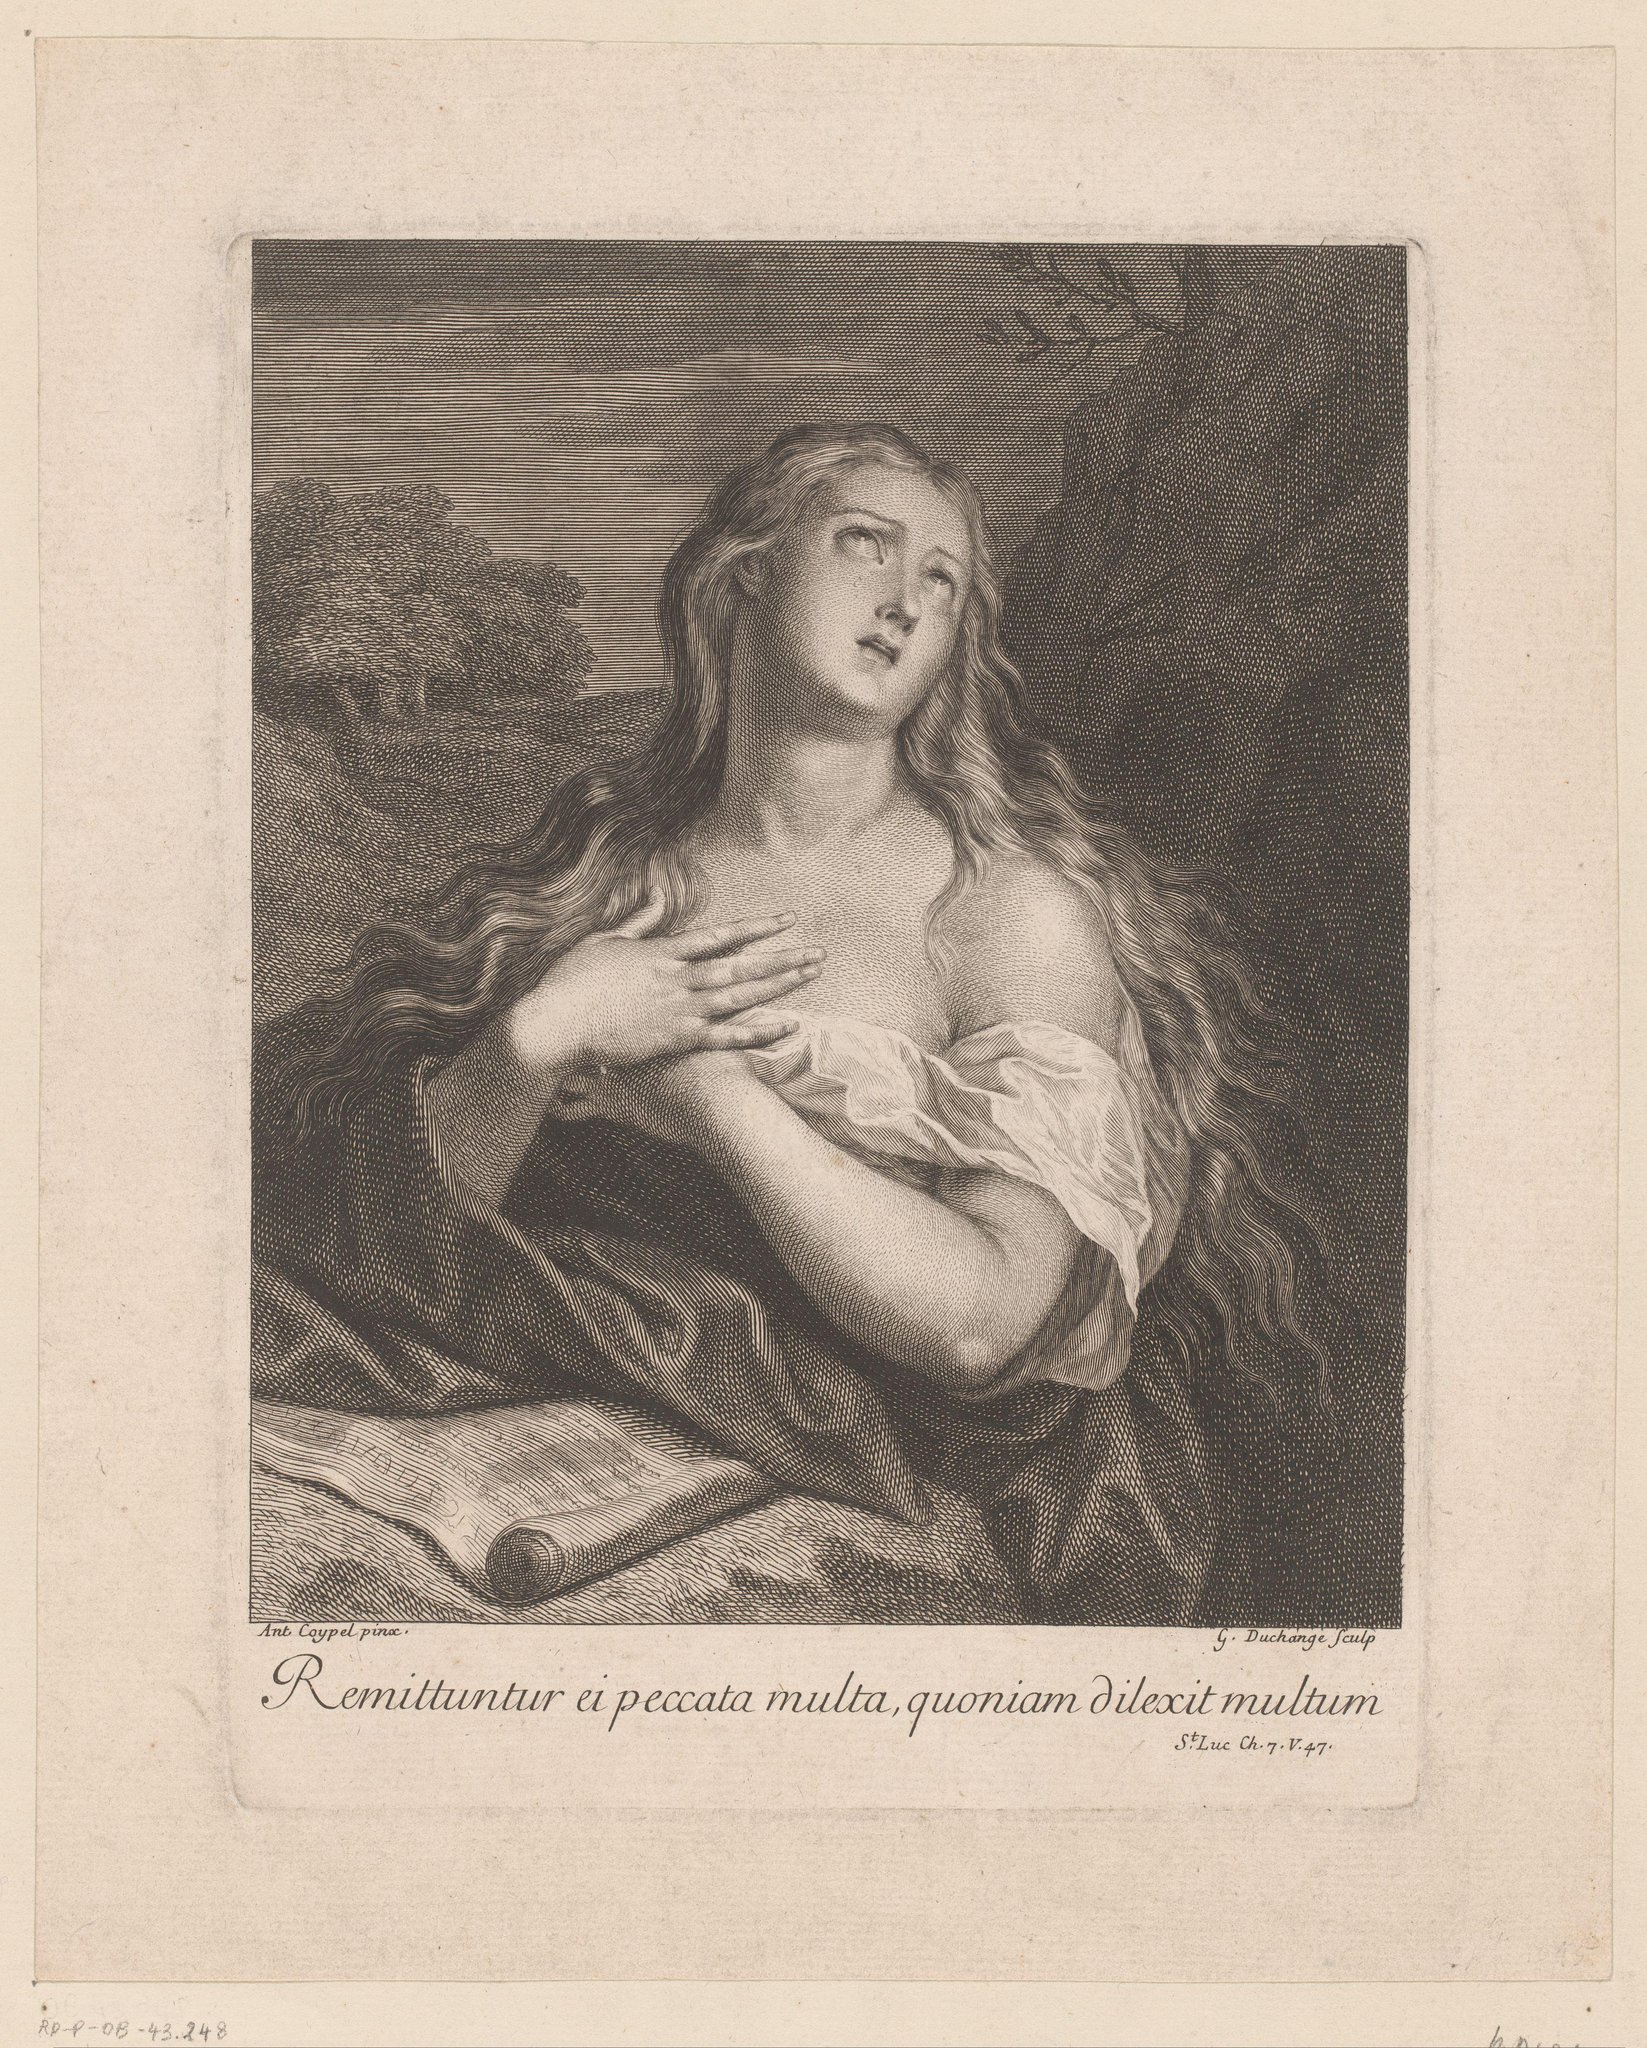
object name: print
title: Boetedoenende Maria Magdalena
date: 1672-1757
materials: paper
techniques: engraving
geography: france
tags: the penitent st. mary magdalene (often before a cave, possibly at la sainte-baume hill): her long hair covers her (naked) body, she reads, meditates or raises her tear-filled eyes towards heaven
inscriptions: collector's mark: Lugt 240